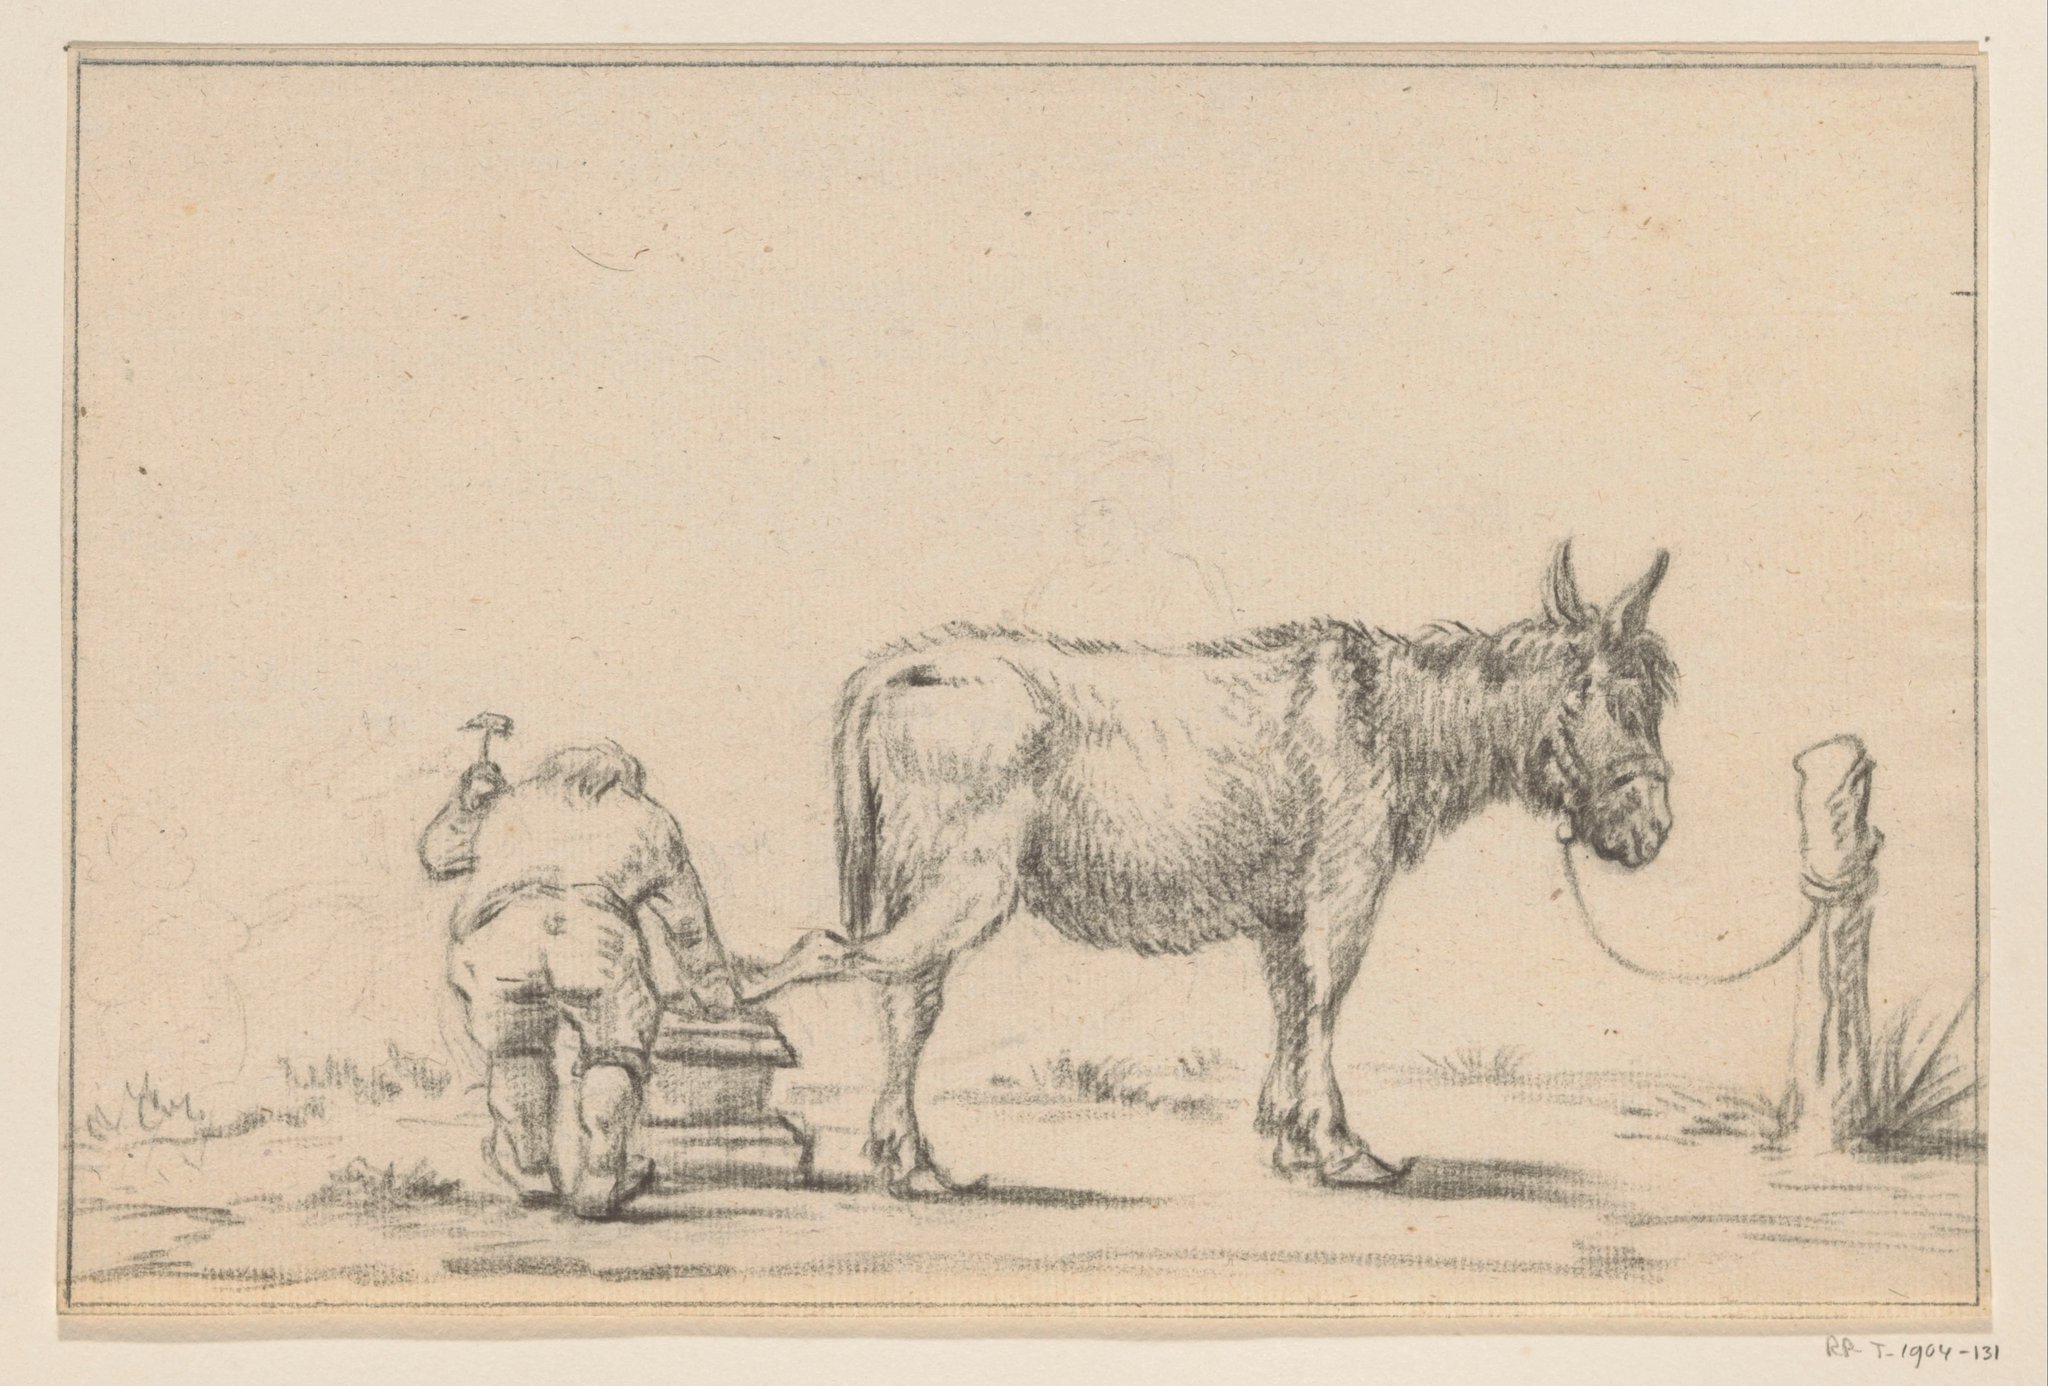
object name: drawing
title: Een ezel krijgt een hoefijzer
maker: jean bernard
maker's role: draughtsman, print maker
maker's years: 1765-1833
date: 1775-1833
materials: chalk, paper, pencil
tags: farrier, shoeing-smith, ass, donkey